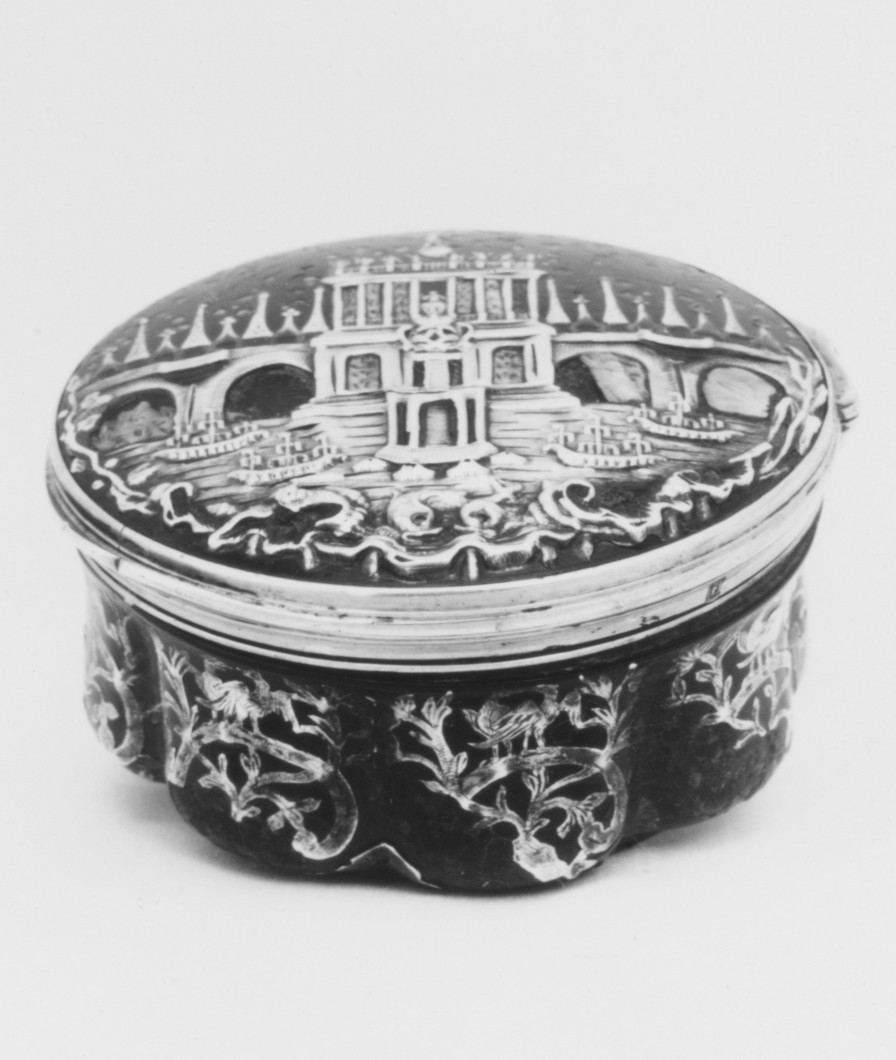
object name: snuffbox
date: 1740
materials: mother of pearl, silver, shell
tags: bridges,boats,pavilions